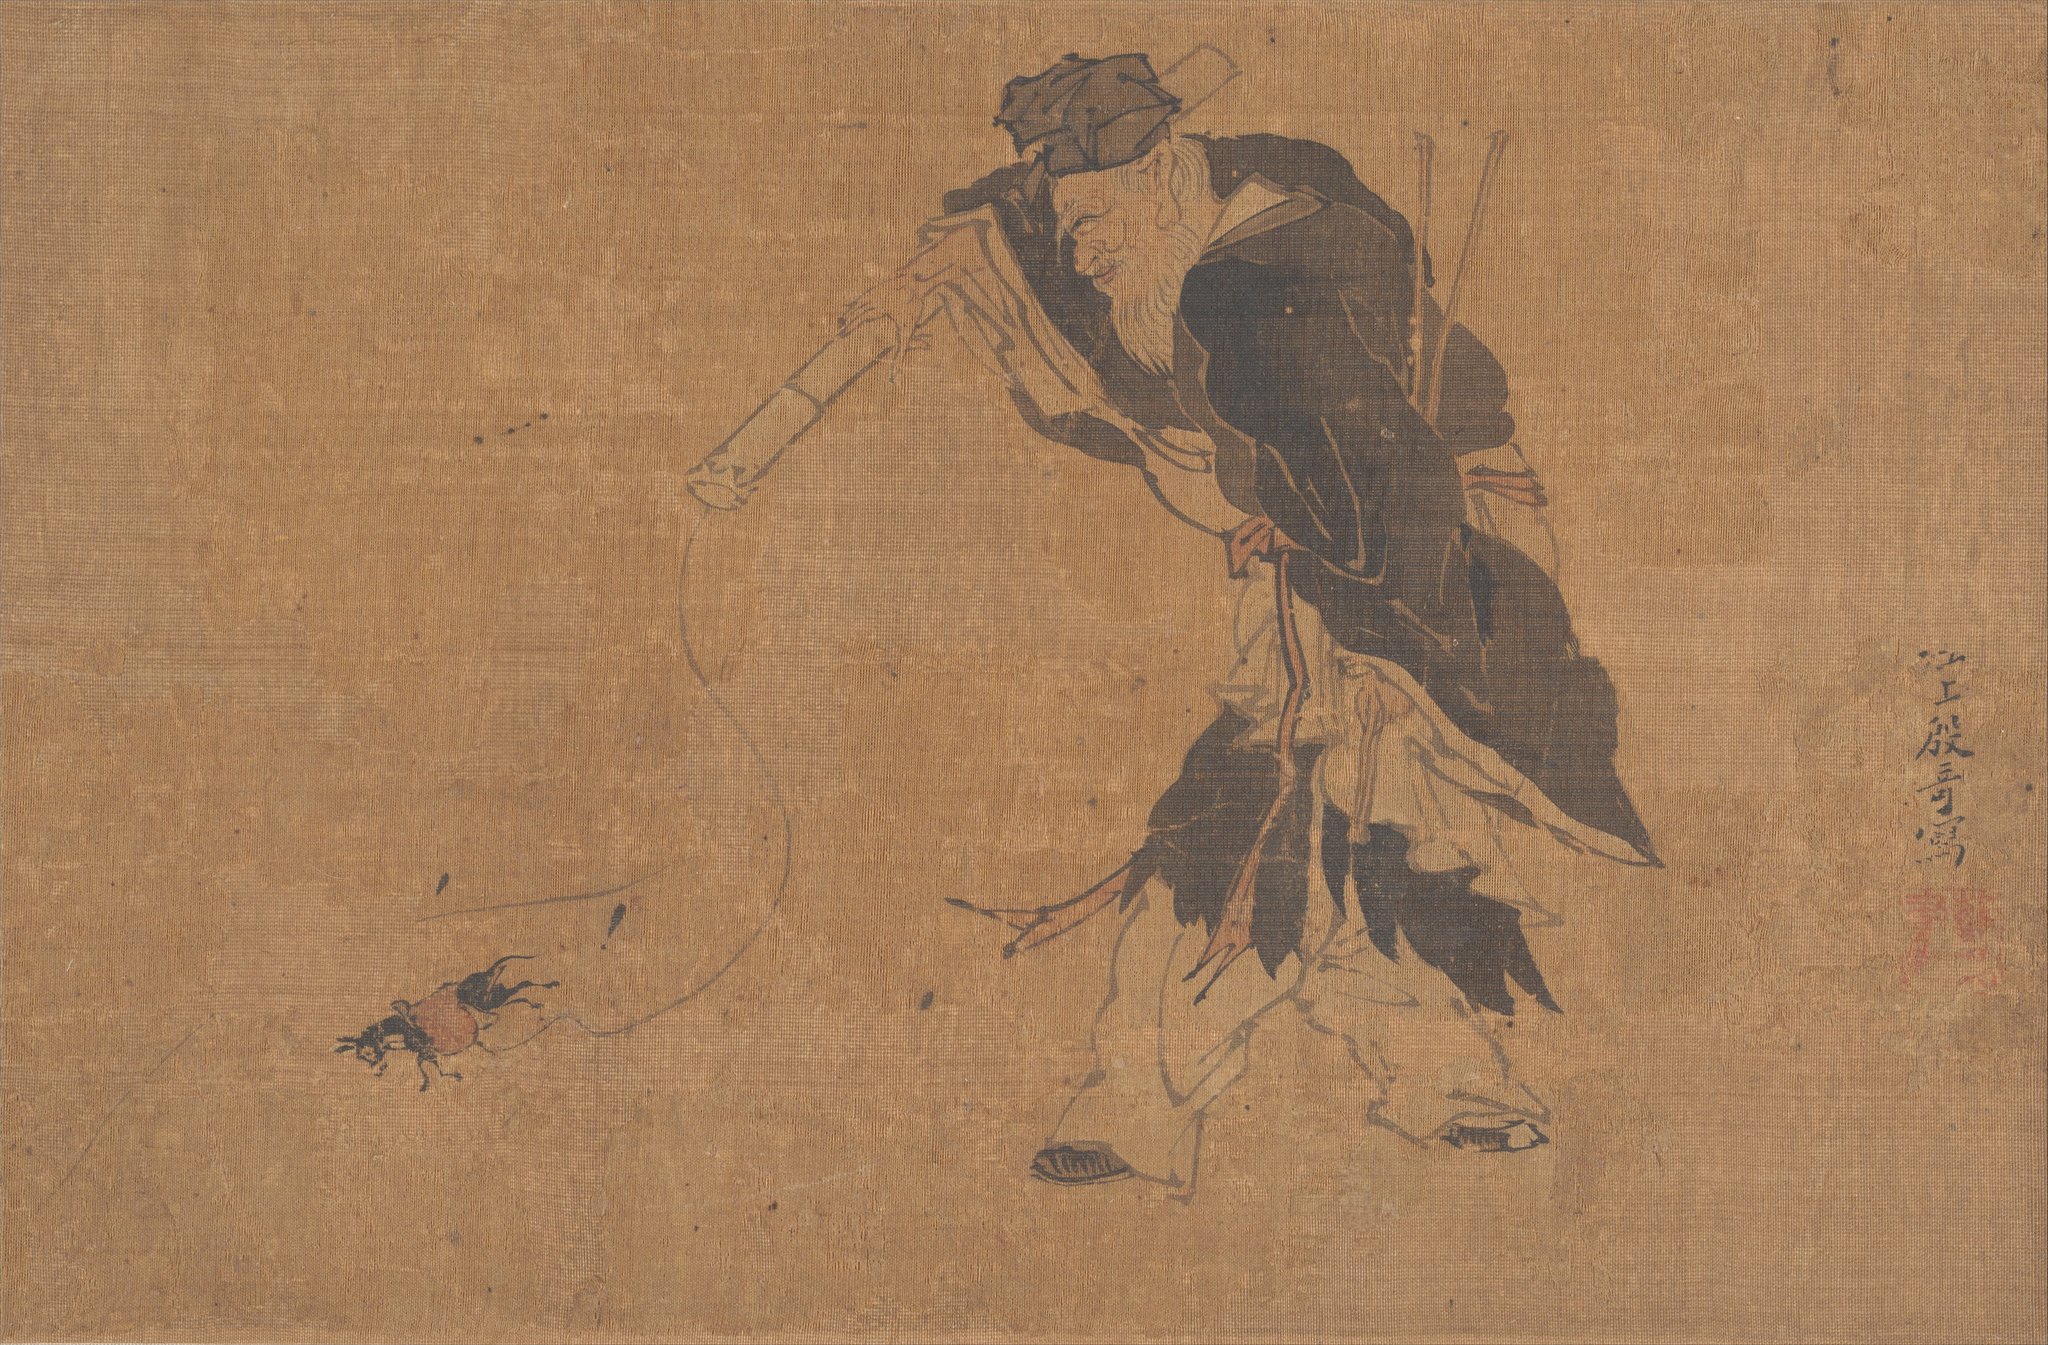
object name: album leaf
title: Zhang Guolao and His Magic Mule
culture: chinese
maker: yin qi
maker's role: artist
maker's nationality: chinese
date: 1368-1911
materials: ink, silk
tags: men,donkeys